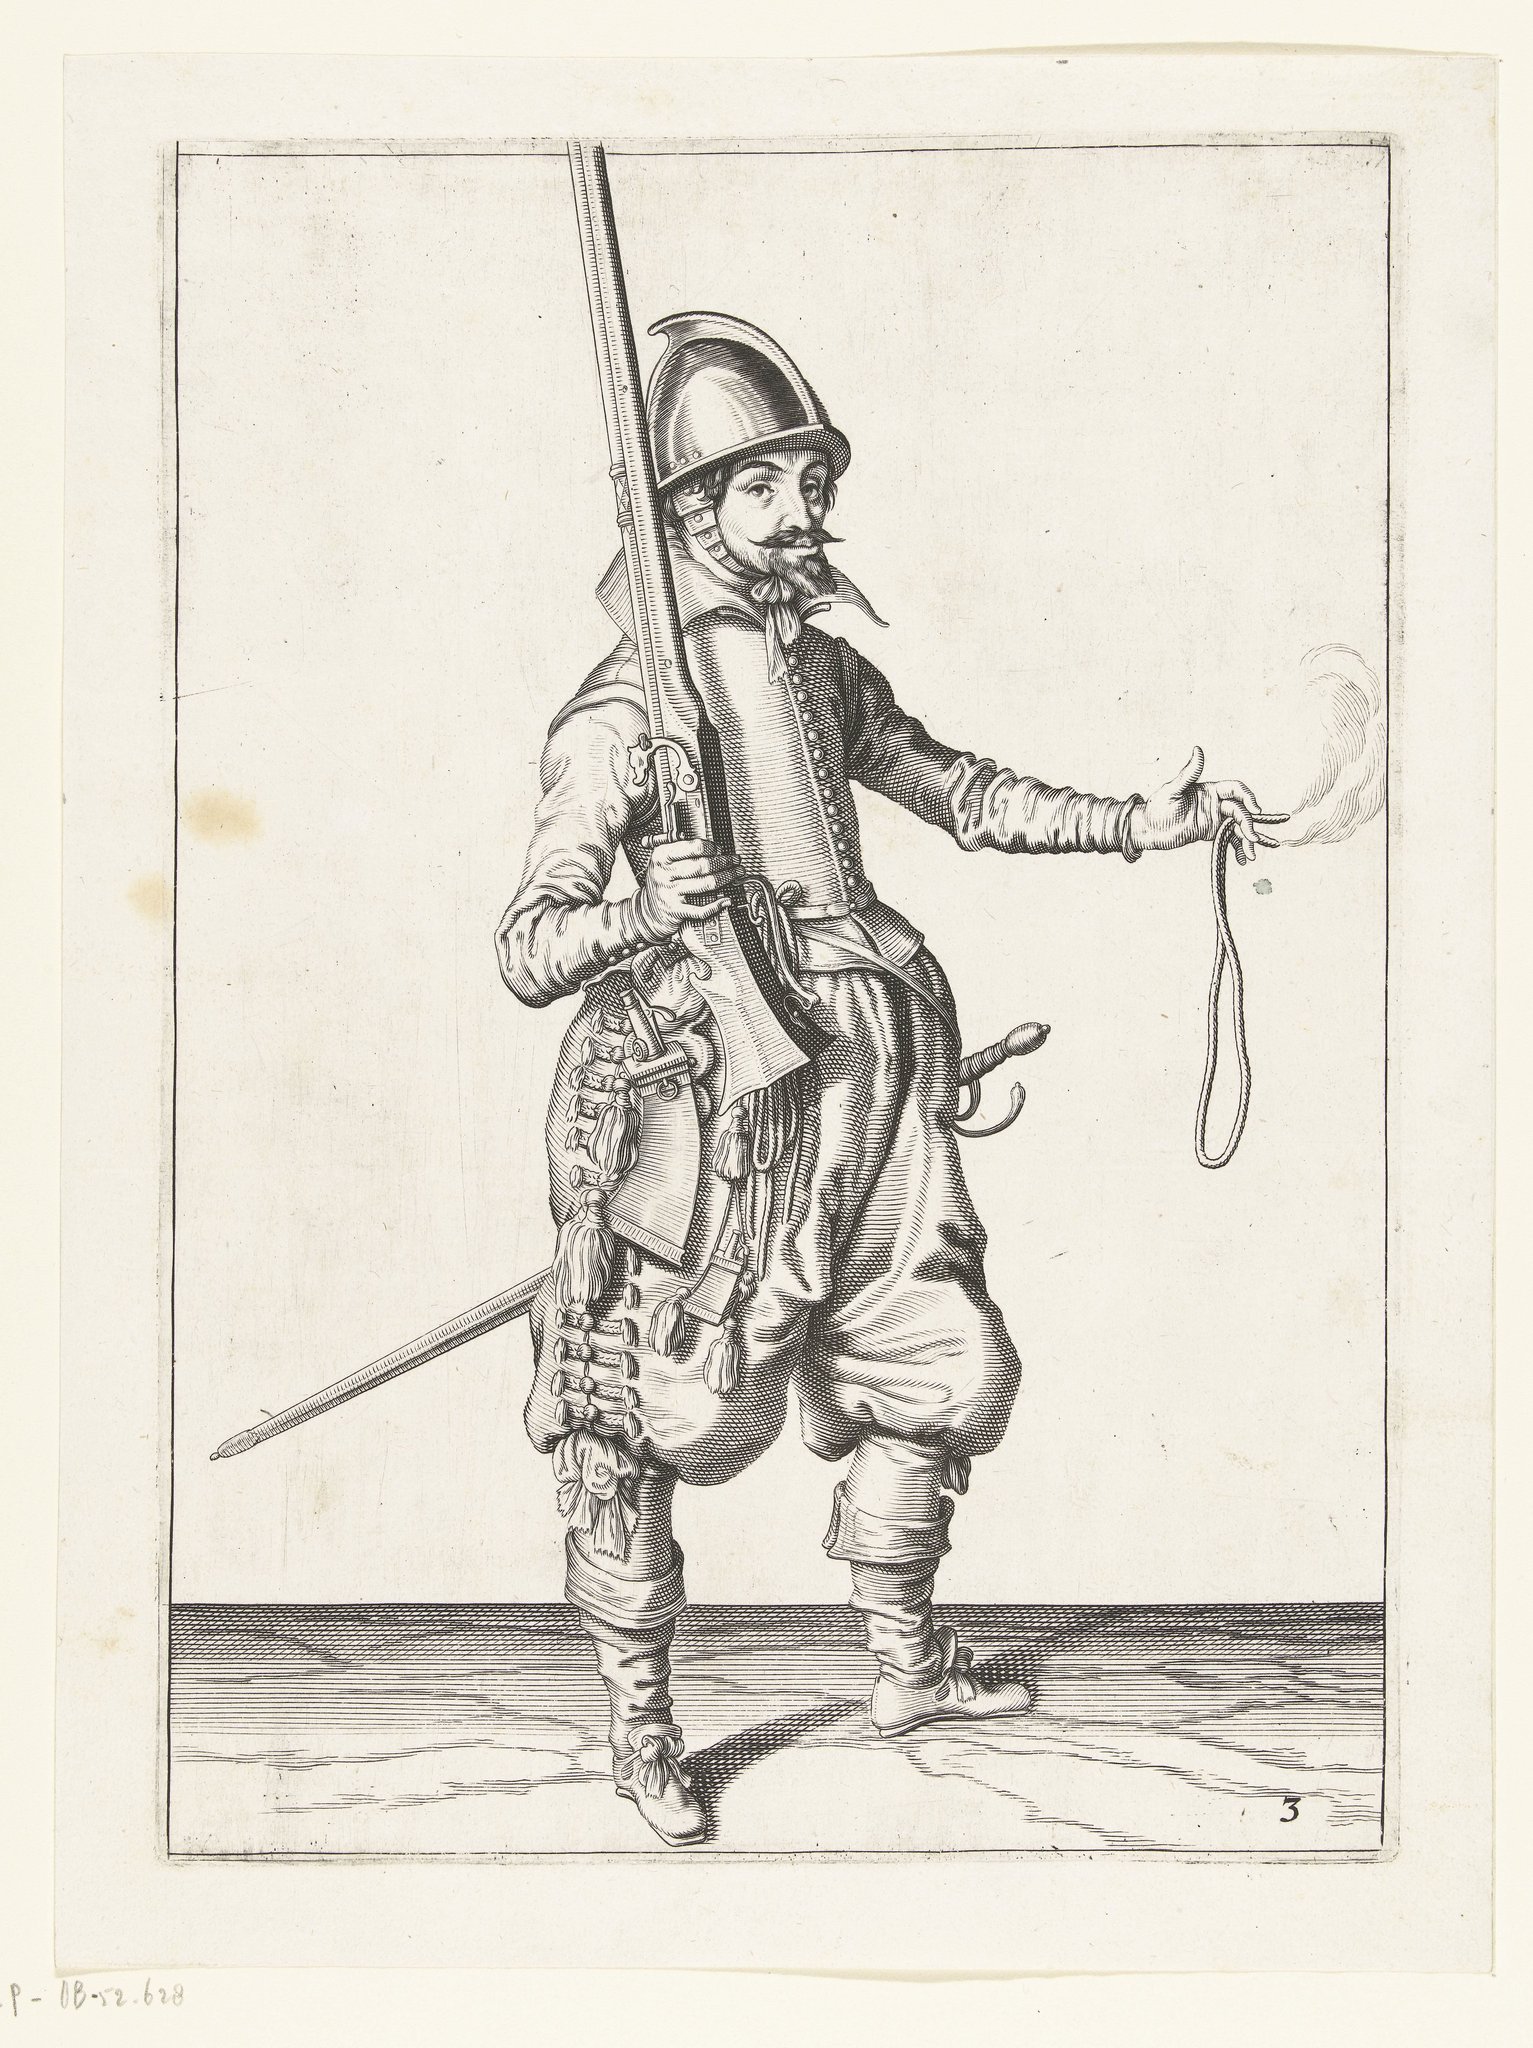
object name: print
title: Wapenhandelinghe van Roers Musquetten ende Spiessen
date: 1597-1607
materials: paper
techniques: engraving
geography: netherlands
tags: manoeuvre ~ military training, firearms: rifle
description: Een soldaat, ten voeten uit, naar rechts, die een roer (een bepaald type vuurwapen) met zijn rechterhand vasthoudt, de loop omhoog wijzend, alvorens zijn wapen over te brengen naar zijn linkerhand. In zijn uitgestoken linkerhand een brandende lont. Deze prent is onderdeel van de reeks van 42 genummerde prenten van roerschutters uit de Wapenhandelinghe.